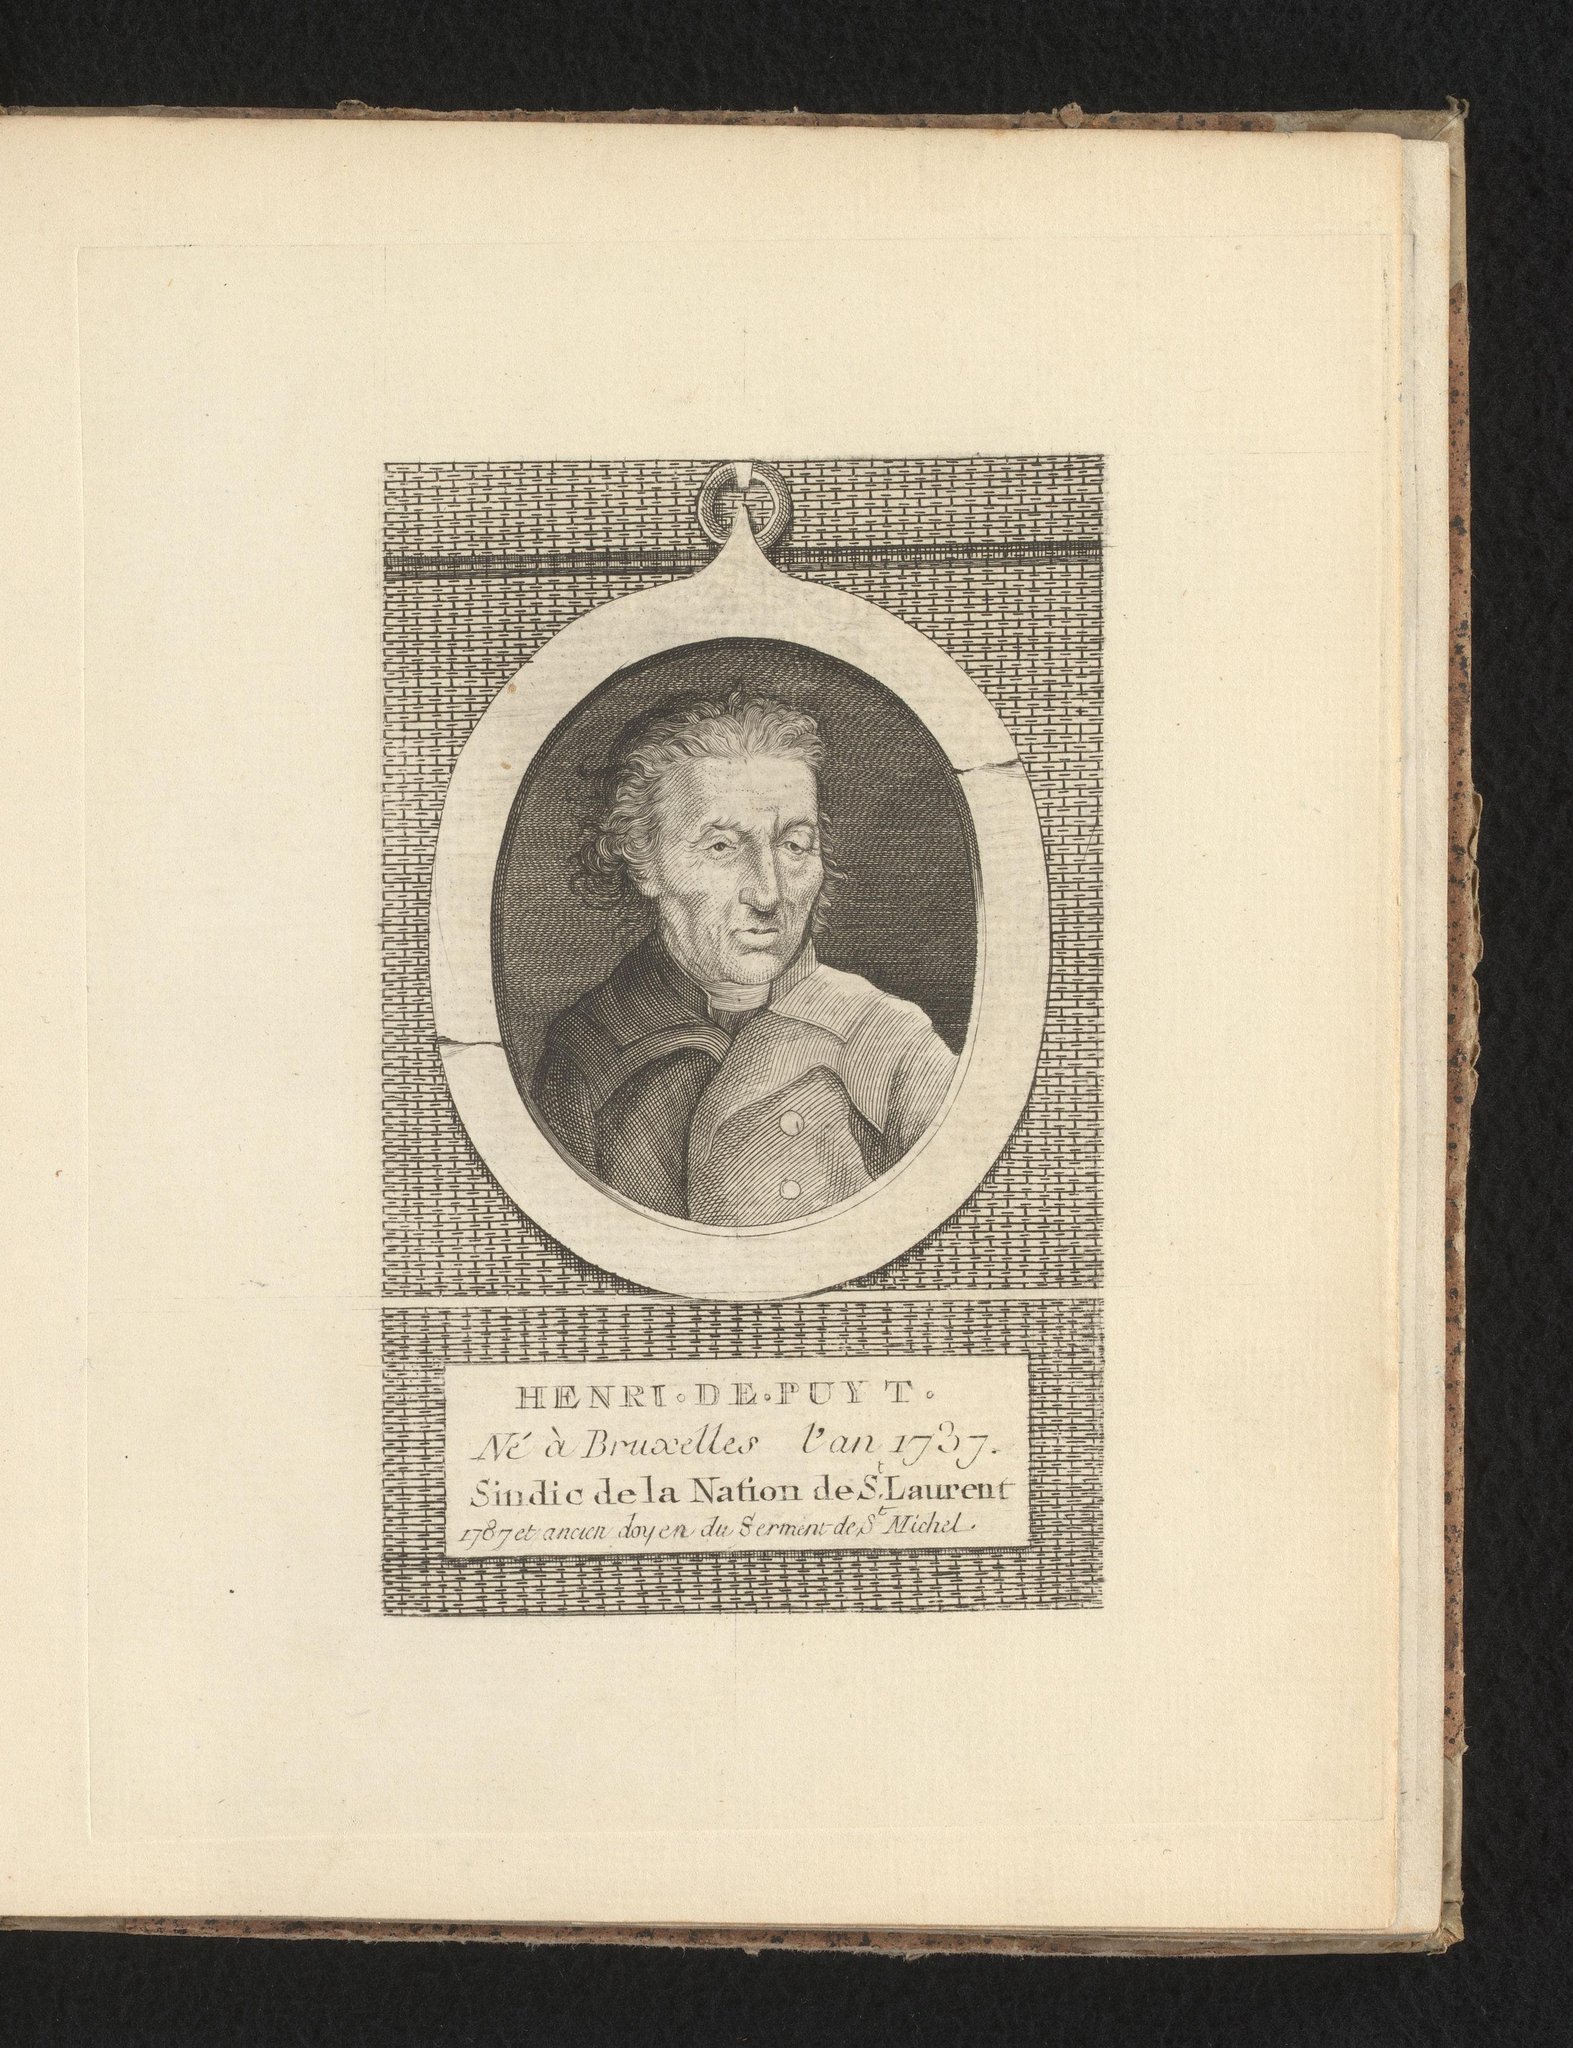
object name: print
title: Henri. de Puyt. Né à Bruxelles l'an 1737. Sindic de la Nation de S. Laurent 1787 (...)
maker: j.f. de la rue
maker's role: print maker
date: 1787-1790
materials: paper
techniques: engraving, etching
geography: southern netherlands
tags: brussels, brabant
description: Portret van Henri de Puyt, in 1787 vertegenwoordiger van Saint-Laurent. Onderdeel van de gebundelde verzameling prenten betrekking hebbend op de gebeurtenissen van de Brabantse Omwenteling en de periode 1787-1790.